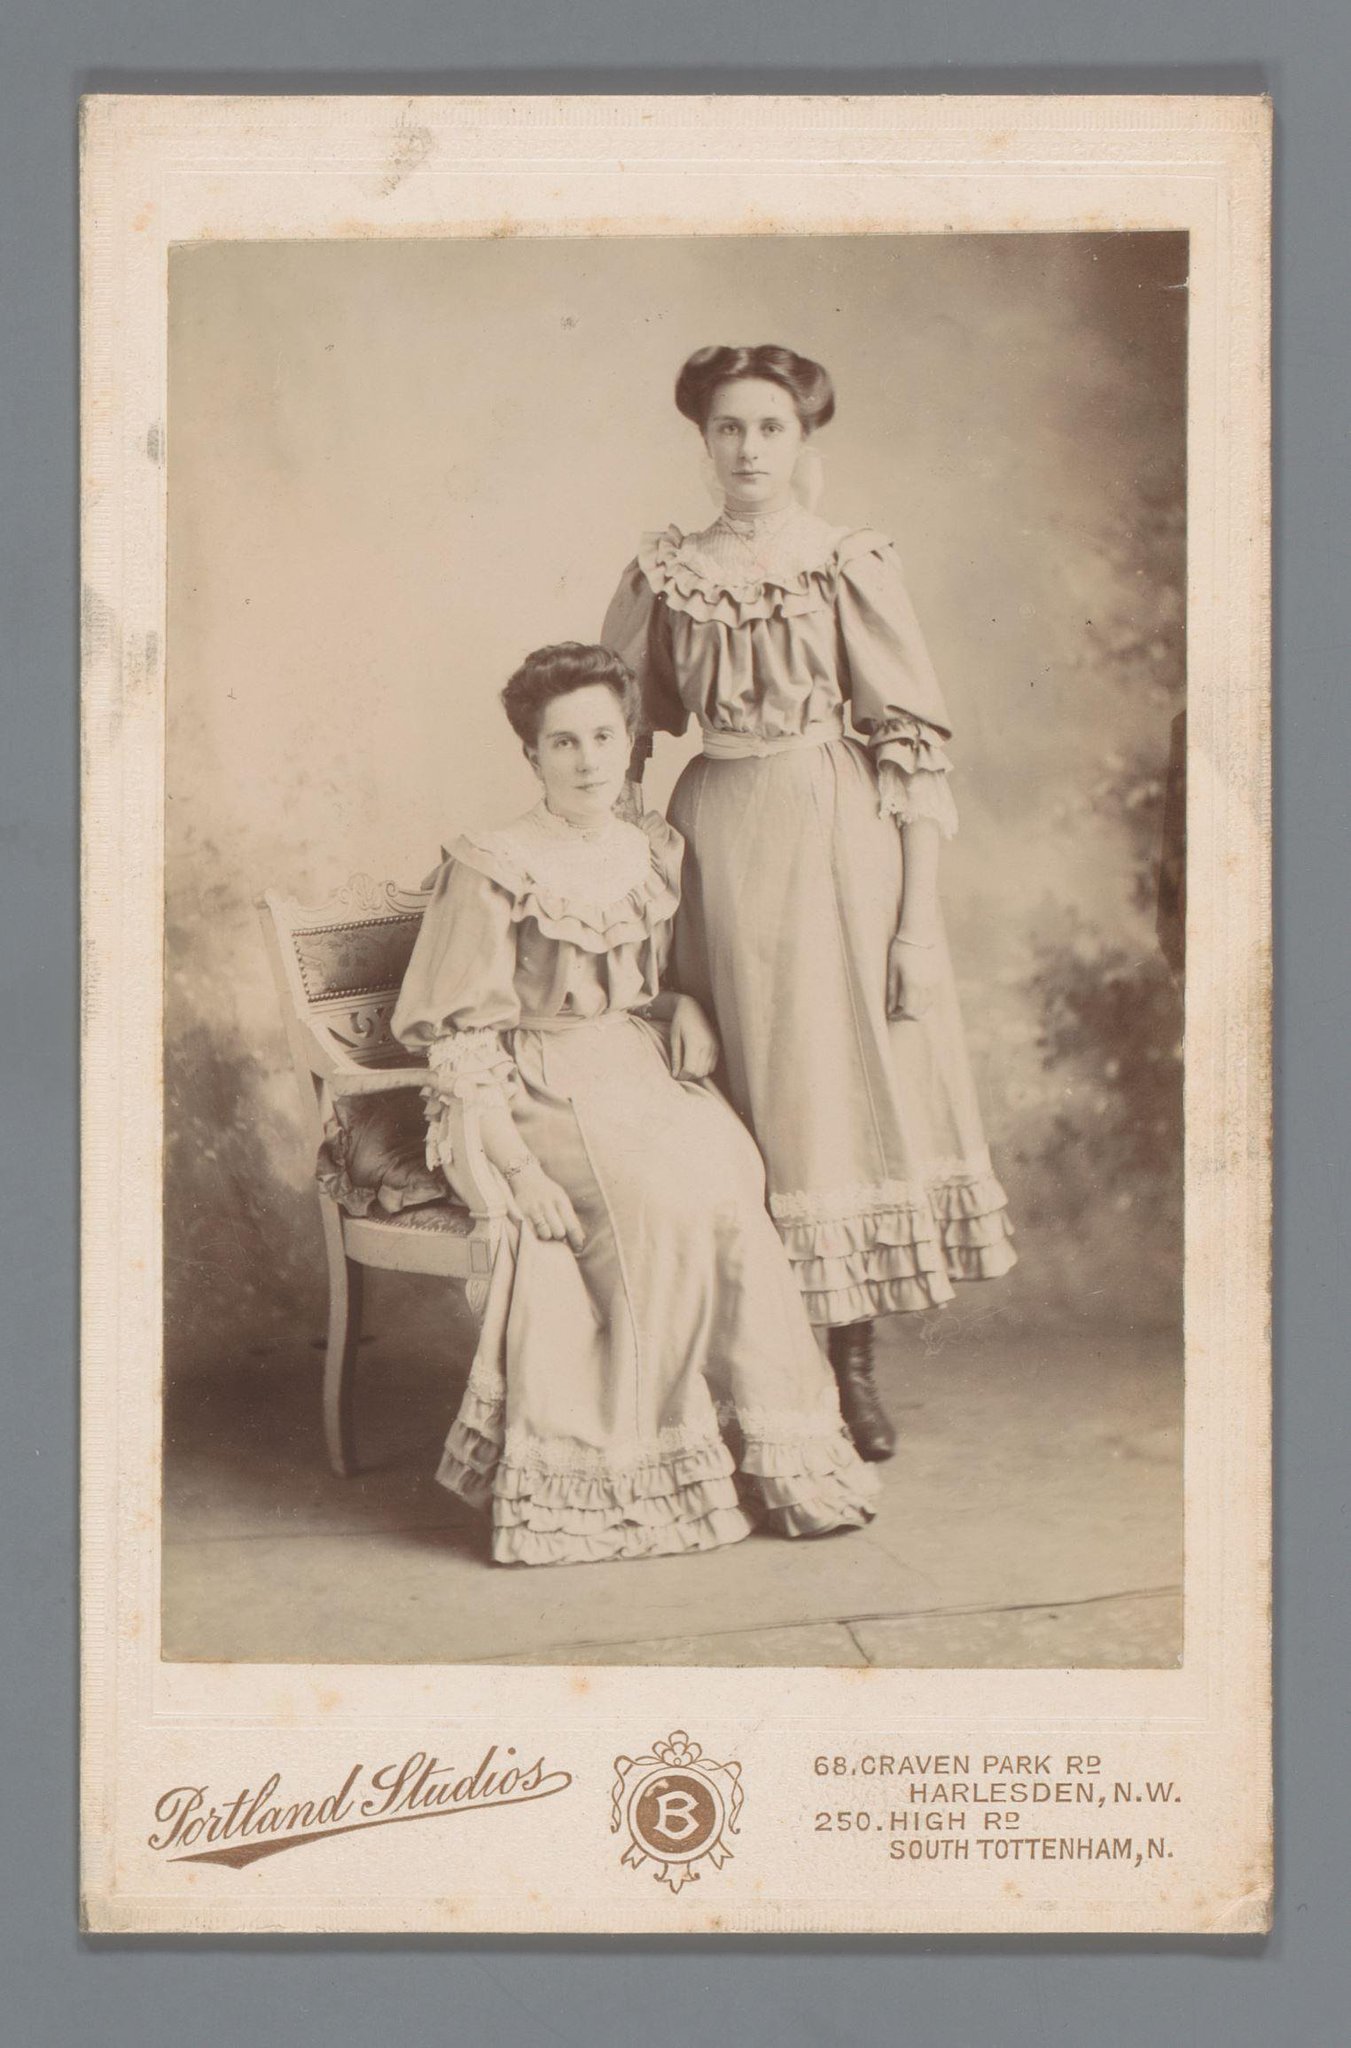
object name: cabinet photograph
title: Studioportret van twee onbekende vrouwen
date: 1885-1905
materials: cardboard, photographic support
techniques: gelatin silver print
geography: london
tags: anonymous historical persons portrayed in a double portrait - bb - woman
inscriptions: name: ‘Portland Studios 68, Graven Park Rd Harlesden, N.W. 250. High Road South Tottenham, N.’